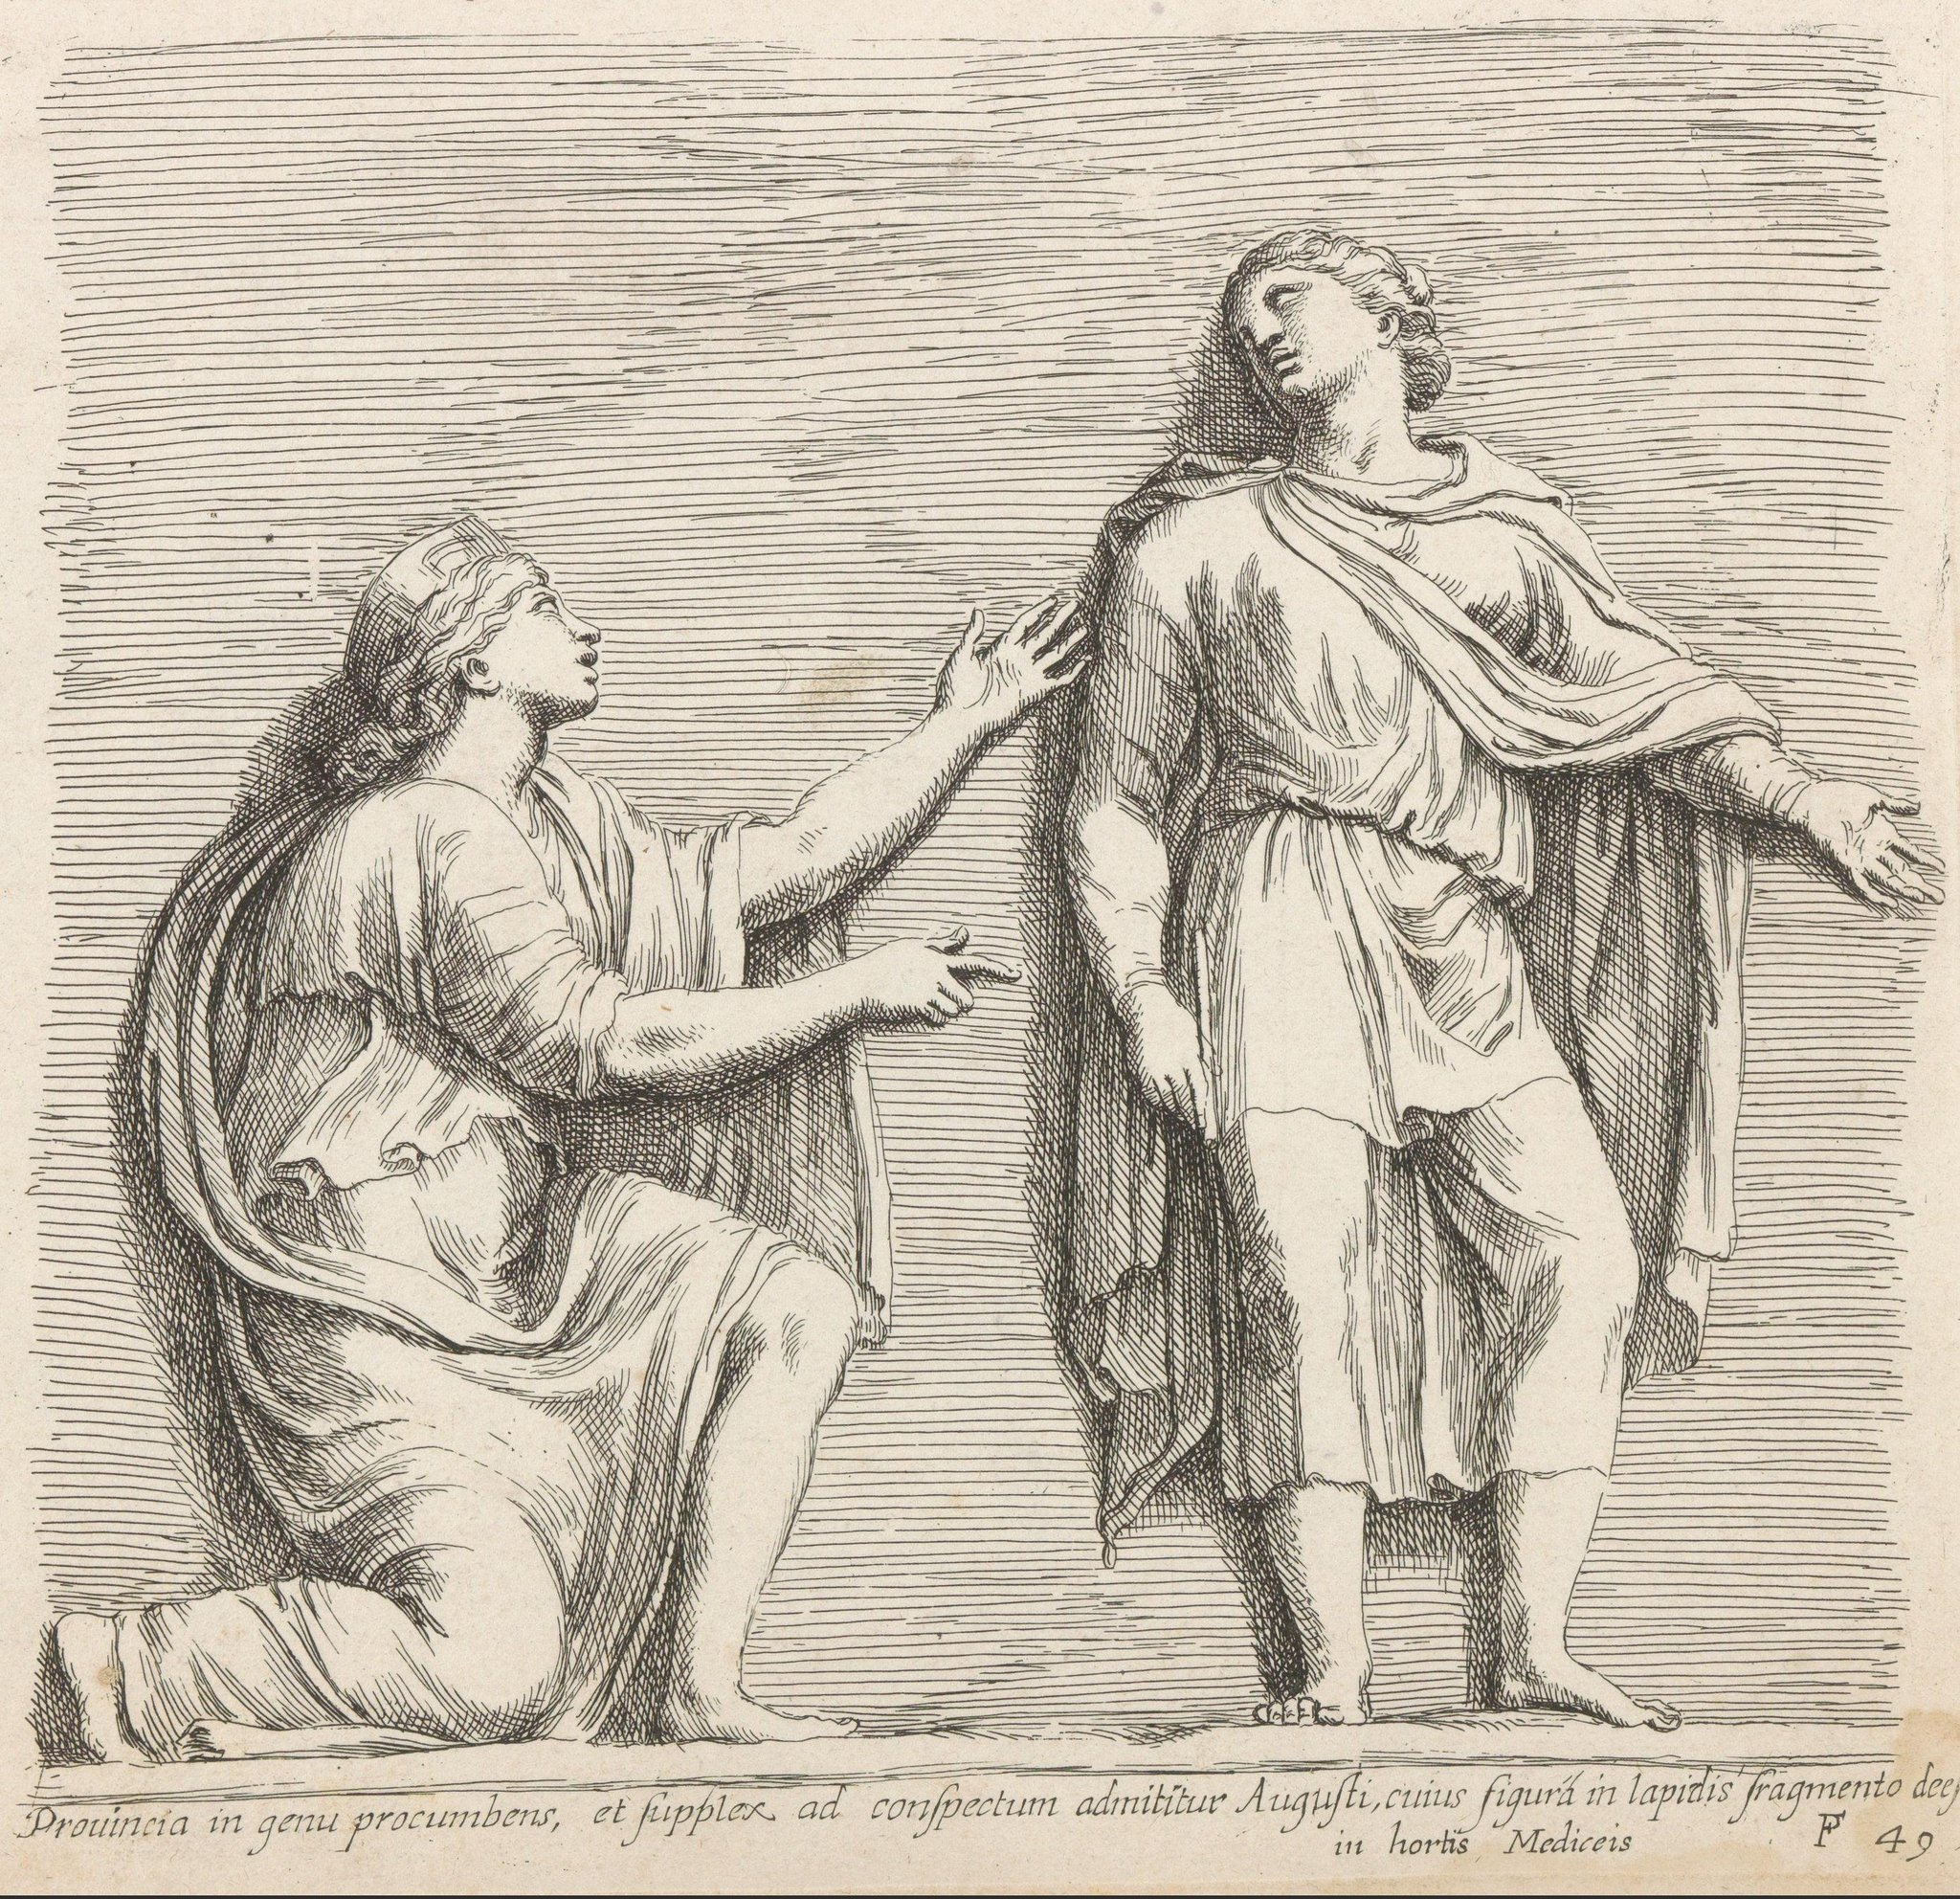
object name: album leaf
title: Romeinse gebeeldhouwde reliëfs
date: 1645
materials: paper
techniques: etching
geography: vatican city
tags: (story of) diana (artemis), (story of) apollo (phoebus), piece of sculpture, reproduction of a piece of sculpture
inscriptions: inscription: ‘Ende lib. No. 5. fol. 74. 75. 111. 115. 135 et.’, number: ‘76’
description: Deze prent maakt deel uit van een reeks van 54 prenten (+ titelprent) naar antieke reliëfs. De nummering op de prenten loopt van 1 tot en met 50. Sommige prenten hebben dubbele nummers. Naar een reliëf in de Villa Medici te Rome.